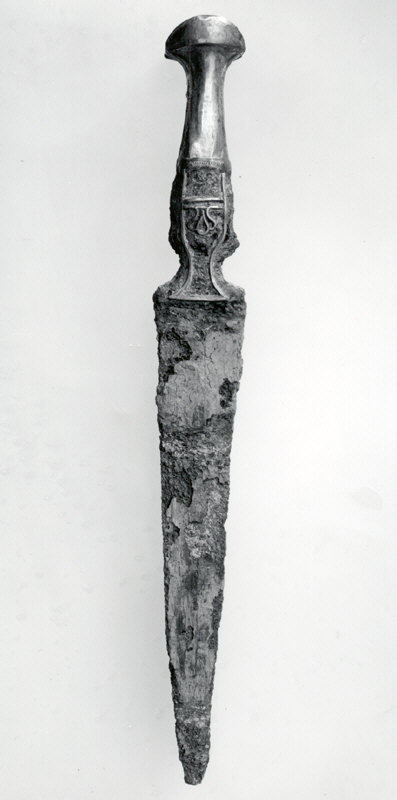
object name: dagger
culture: iranian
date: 1333-1001 BCE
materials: bronze, gold foil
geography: iran